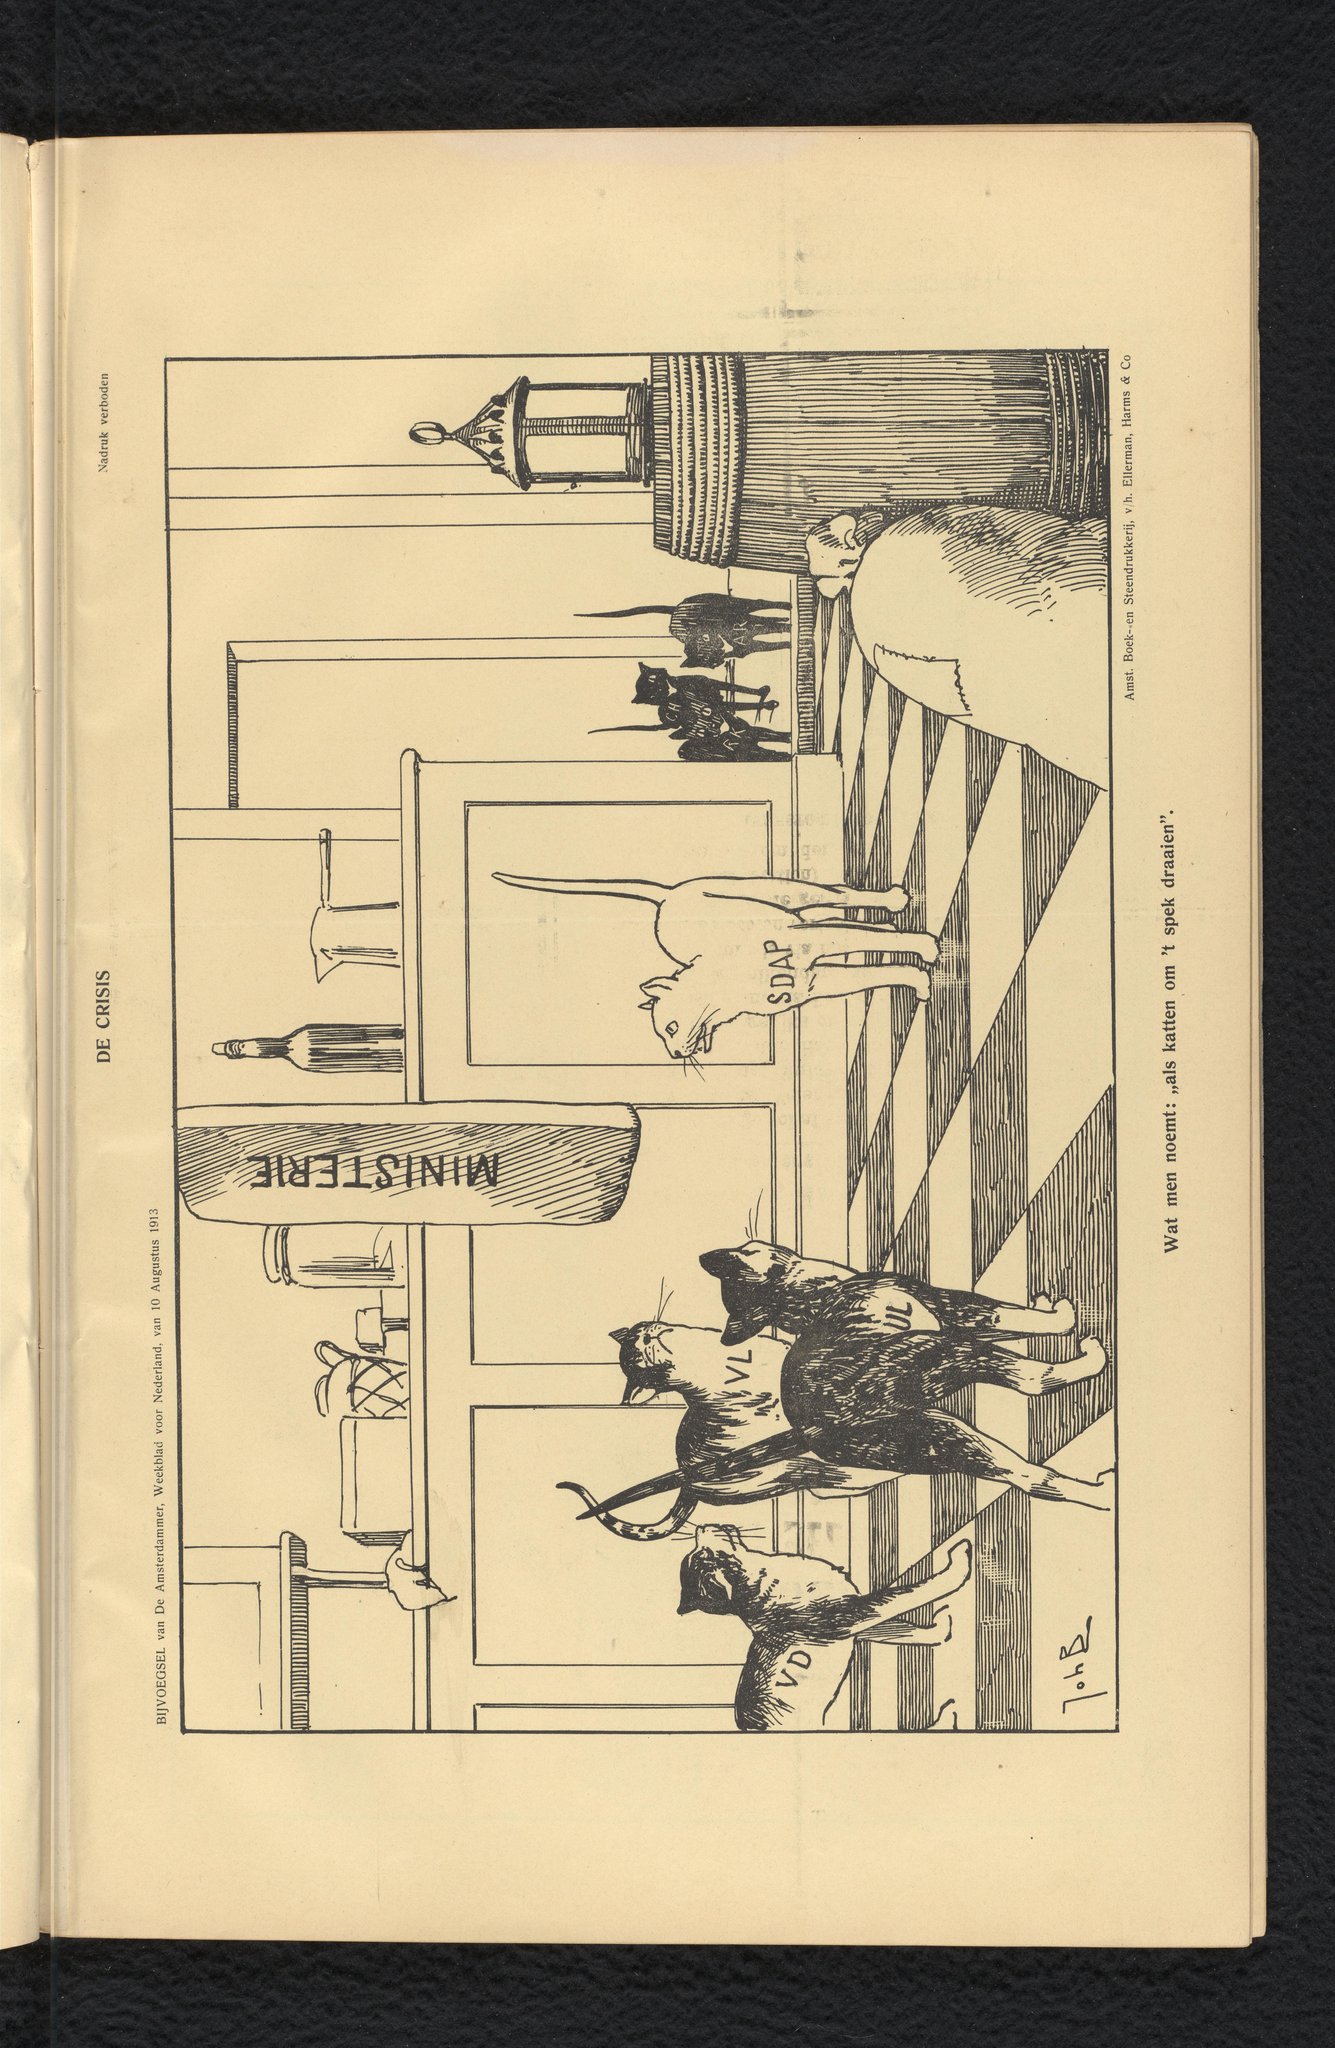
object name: cartoon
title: De Crisis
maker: johan braakensiek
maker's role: draughtsman, print maker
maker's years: 1858-1940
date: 1913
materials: paper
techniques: lithograph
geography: netherlands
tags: cat, political parties, political caricatures and satires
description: Politieke partijen als katten die in een keuken naar een stuk spek aangeduid als 'Ministerie' kijken. Naar aanleiding van de moeizame formatie van een nieuwe regering na de Tweede Kamerverkiezingen van juni 1913.